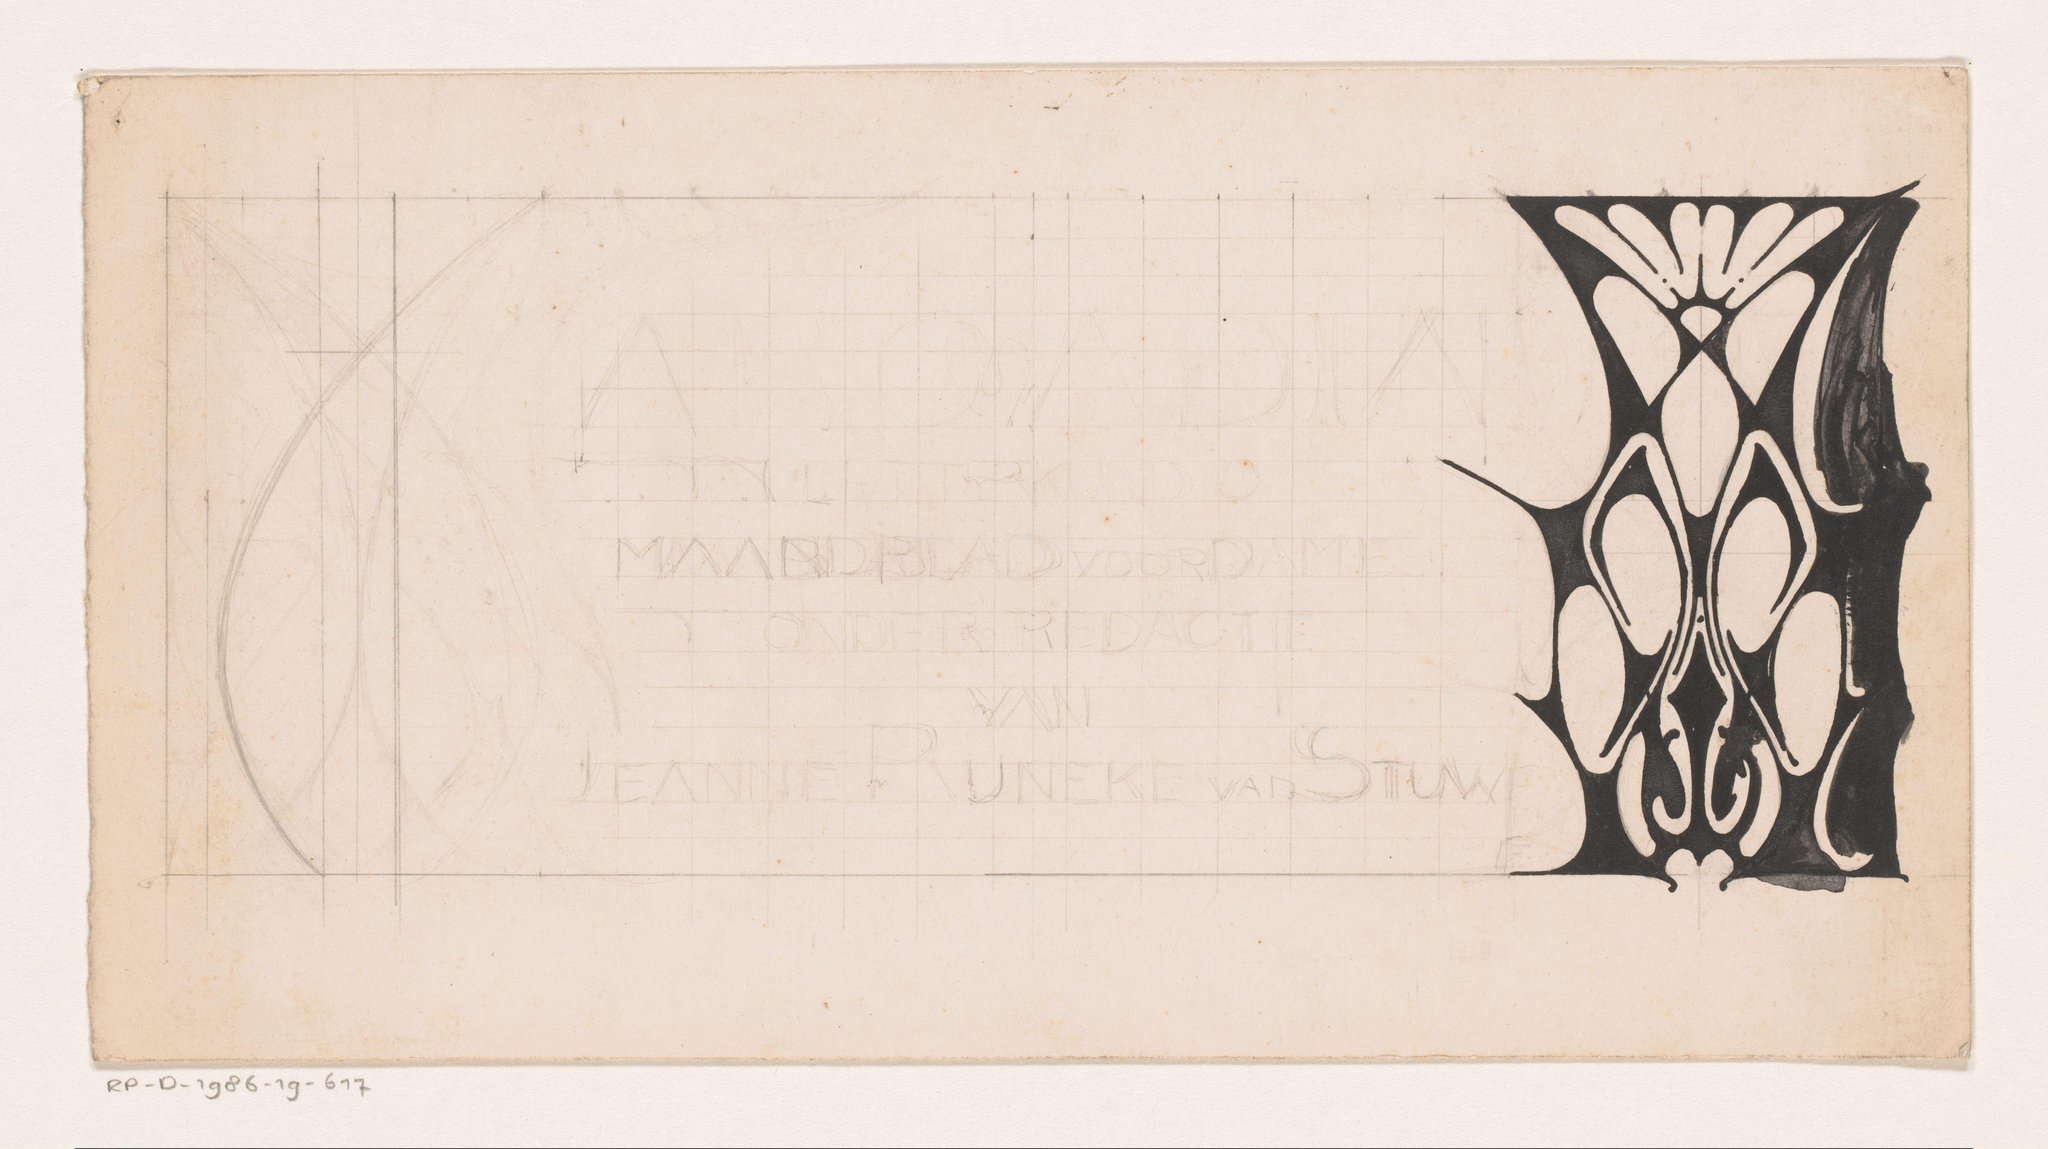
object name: design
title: Ontwerp voor een titelhoofd van: Arcadia, letterkundig maandblad voor dames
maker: reinier willem petrus de vries (1874-1953)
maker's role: draughtsman, print maker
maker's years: 1874-1953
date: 1900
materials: ink, paper, pencil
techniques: brush, pen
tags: flowers ~ ornament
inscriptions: collector's mark: ‘R:MVS.’